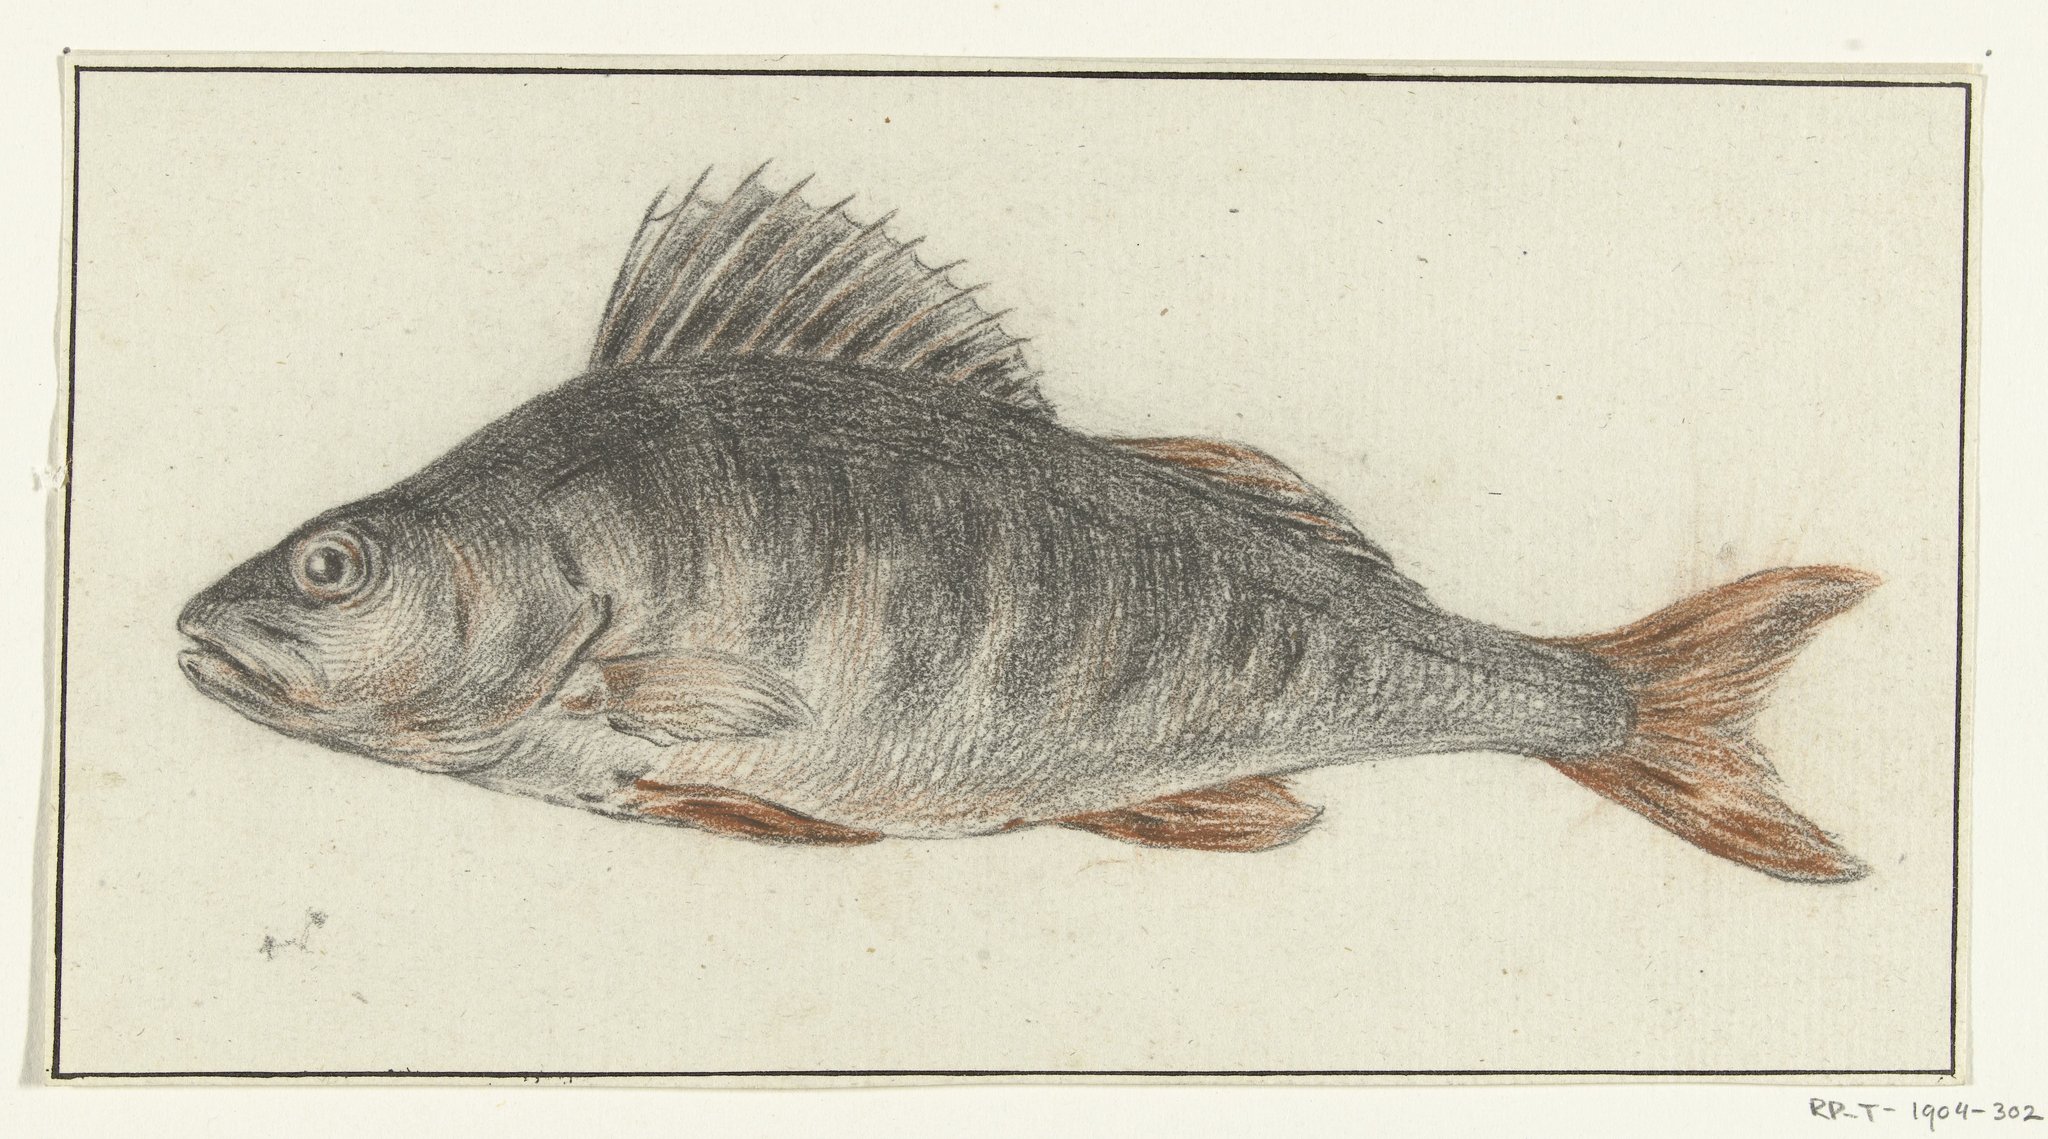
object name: drawing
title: Vis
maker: jean bernard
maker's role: draughtsman, print maker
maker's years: 1765-1833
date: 1775-1833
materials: chalk, paper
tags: bony fishes